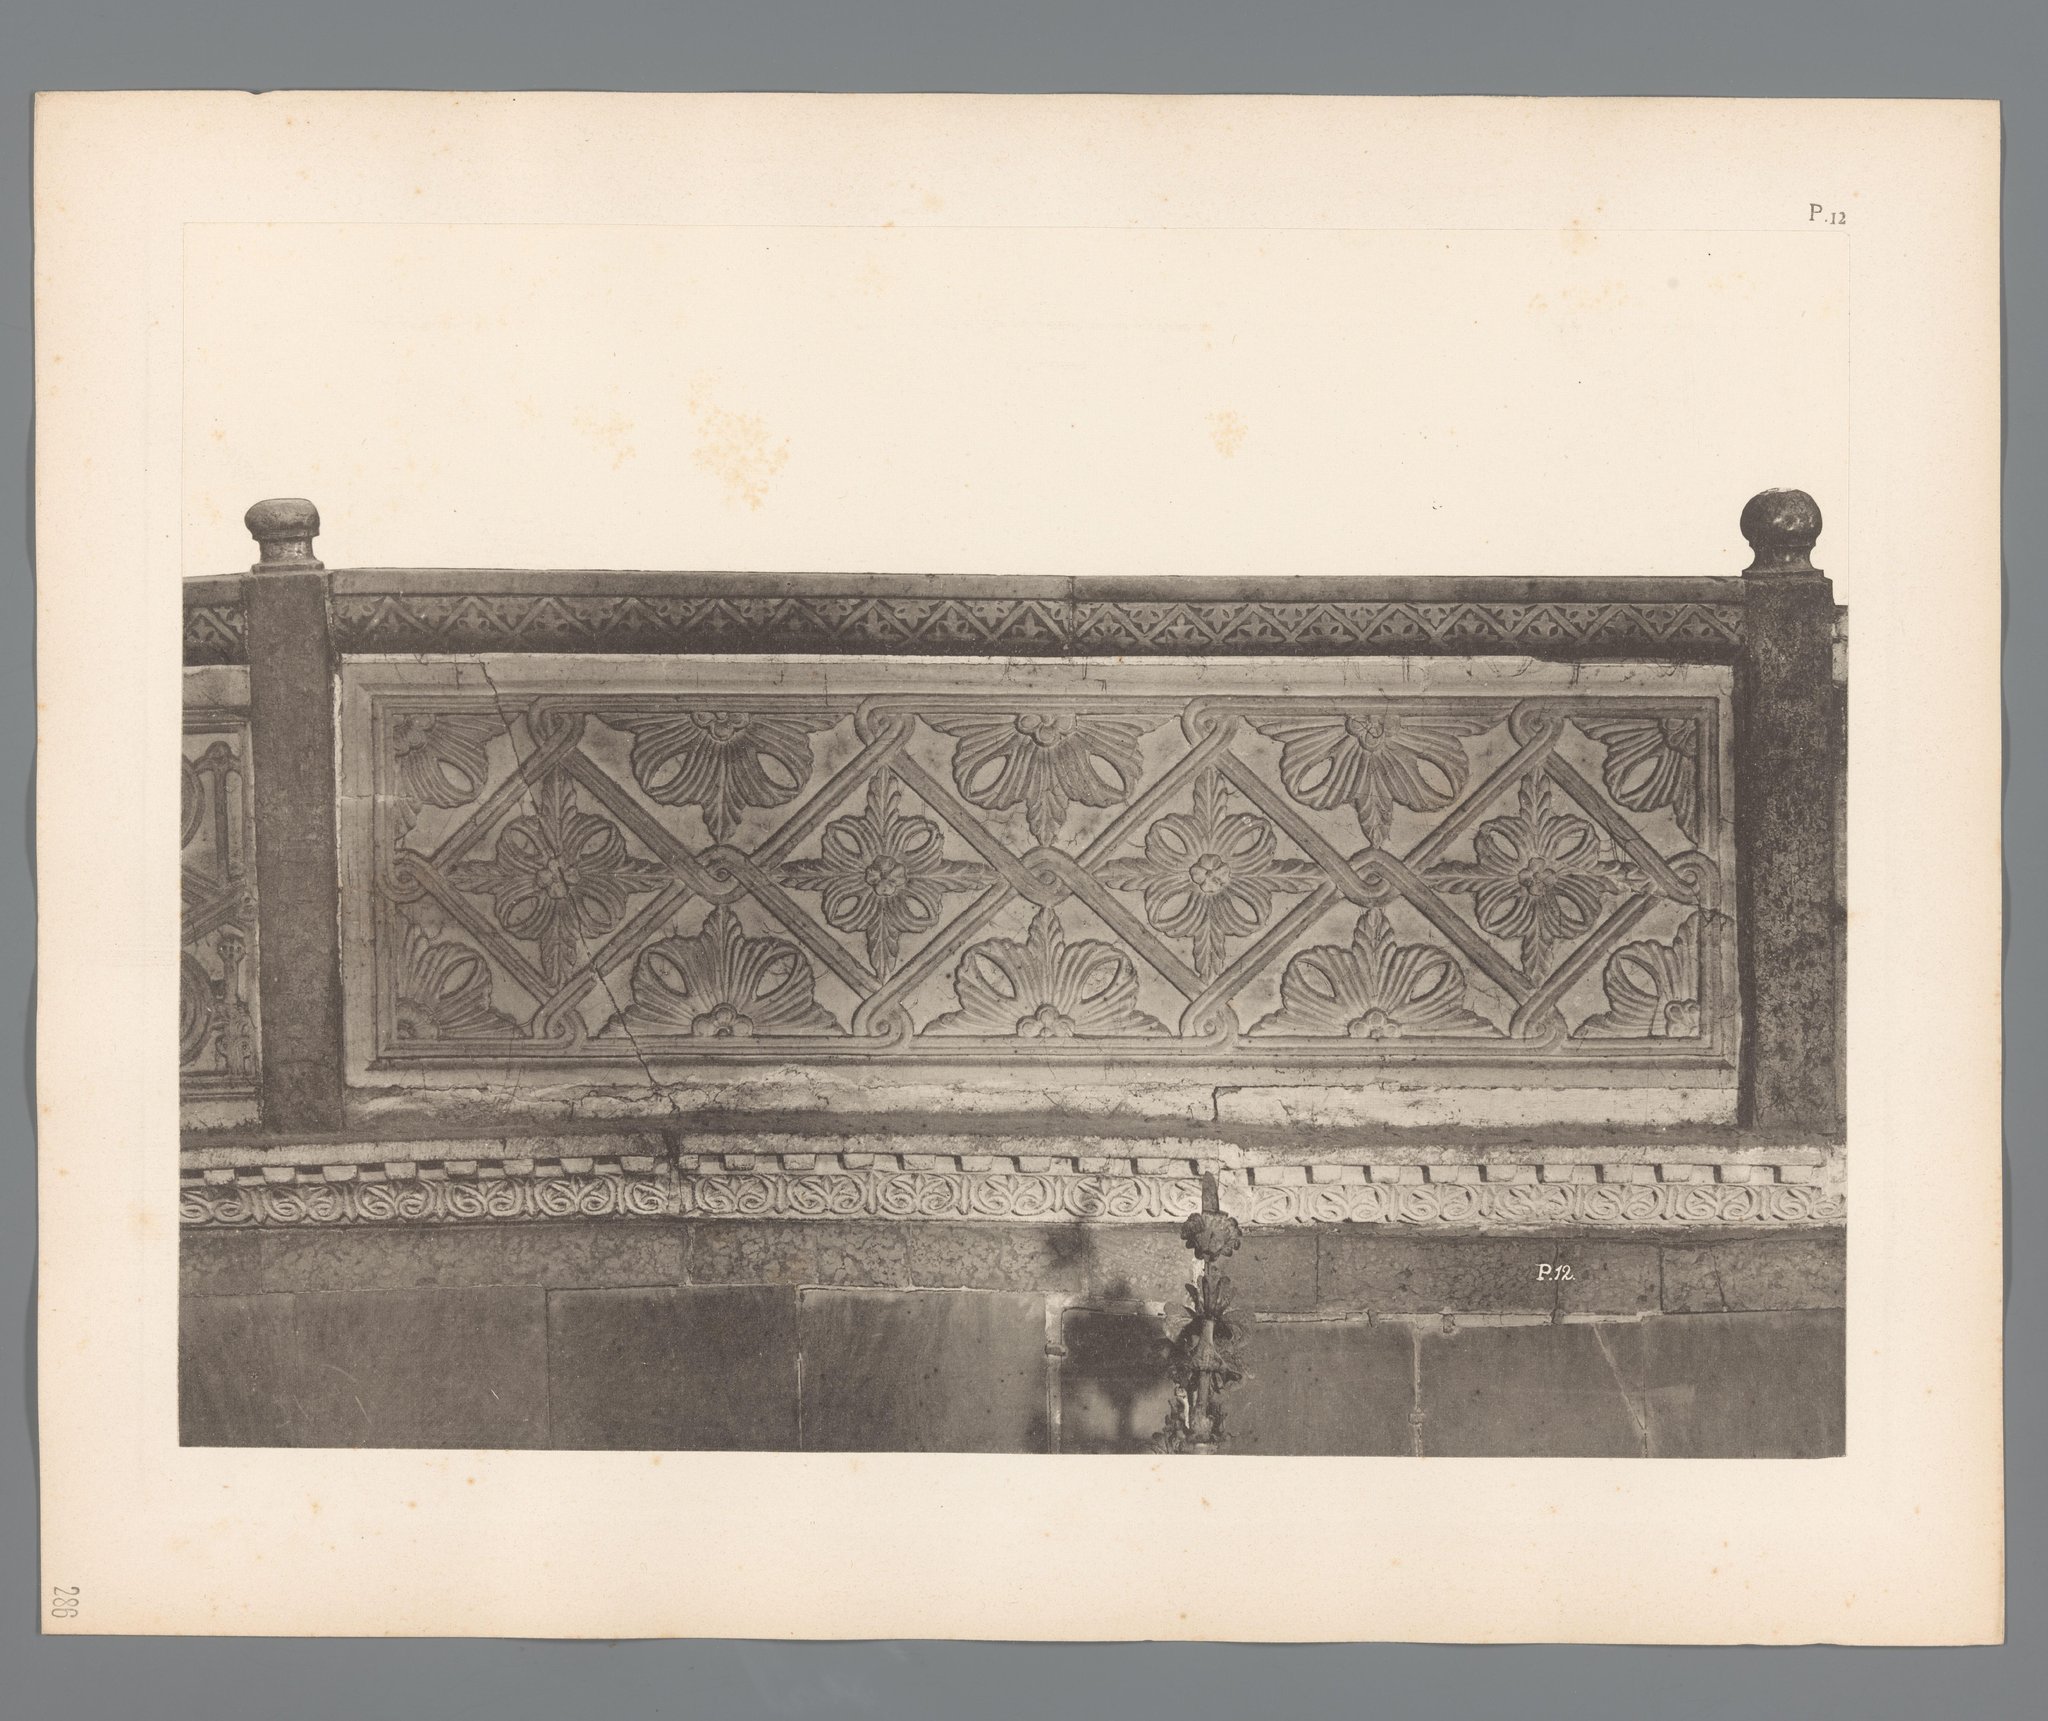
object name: photomechanical print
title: Balustrade met reliëf in de San Marco in Venetië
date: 1880-1885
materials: paper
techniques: photograph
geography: st. mark's basilica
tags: balustrade, piece of sculpture, reproduction of a piece of sculpture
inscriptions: number: ‘286’, number: ‘P.12.’, number: ‘P.12’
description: Deze prent maakt deel uit van een omslag met 58 prenten op 50 bladen.